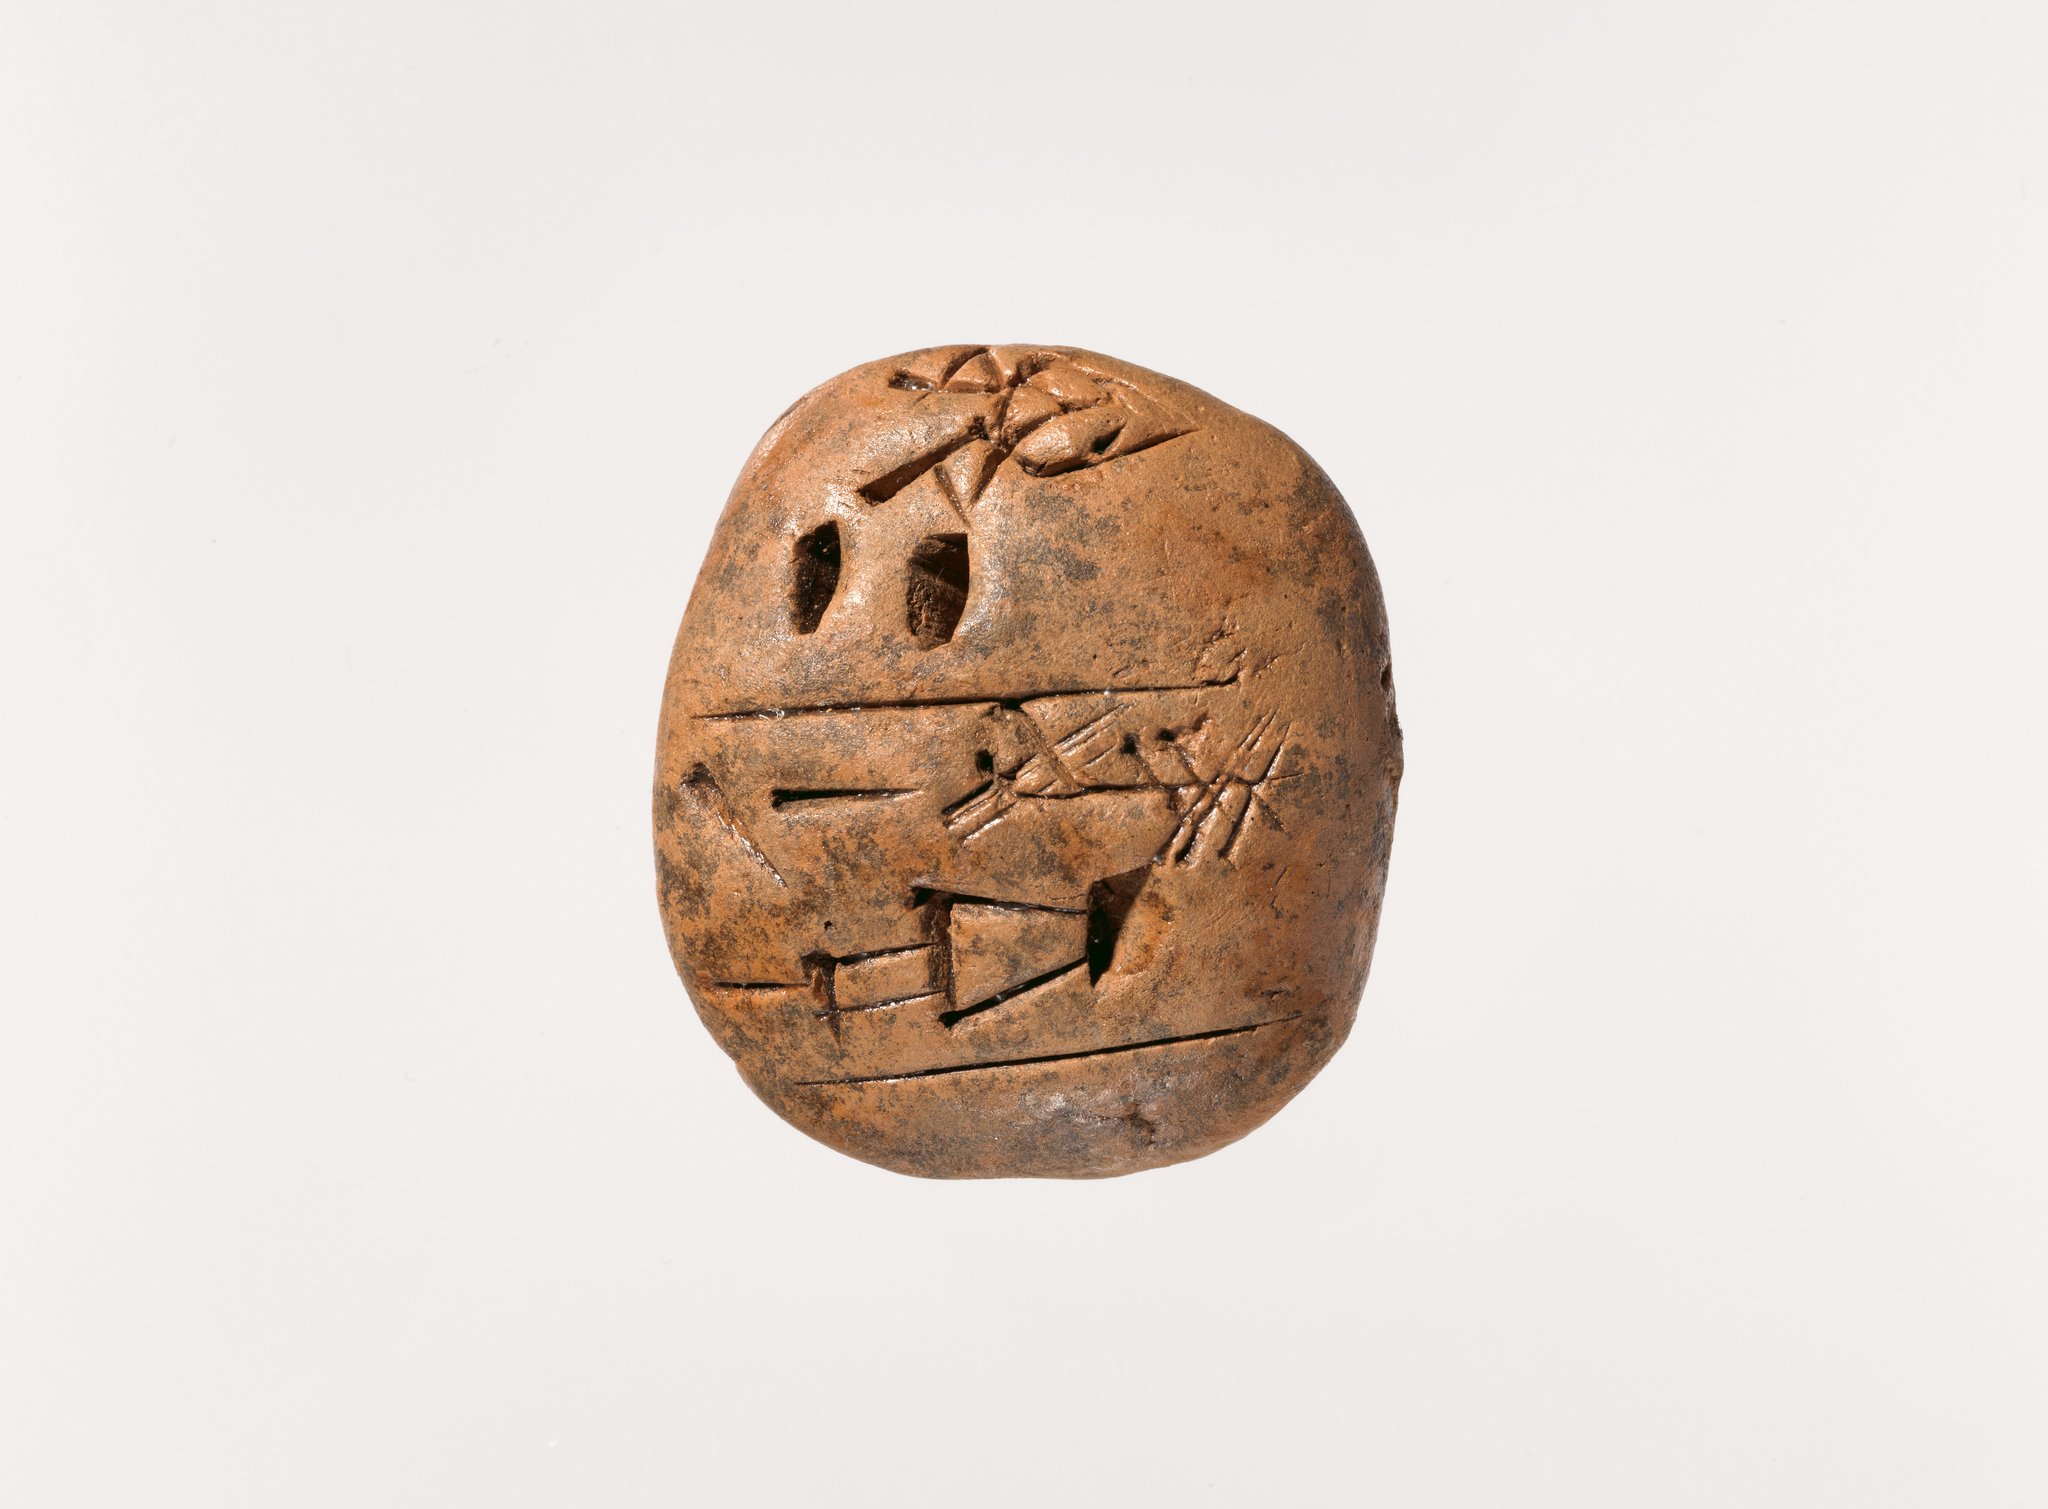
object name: cuneiform tablet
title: Cuneiform tablet: genre uncertain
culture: sumerian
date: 2600-2350 BCE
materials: clay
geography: mesopotamia